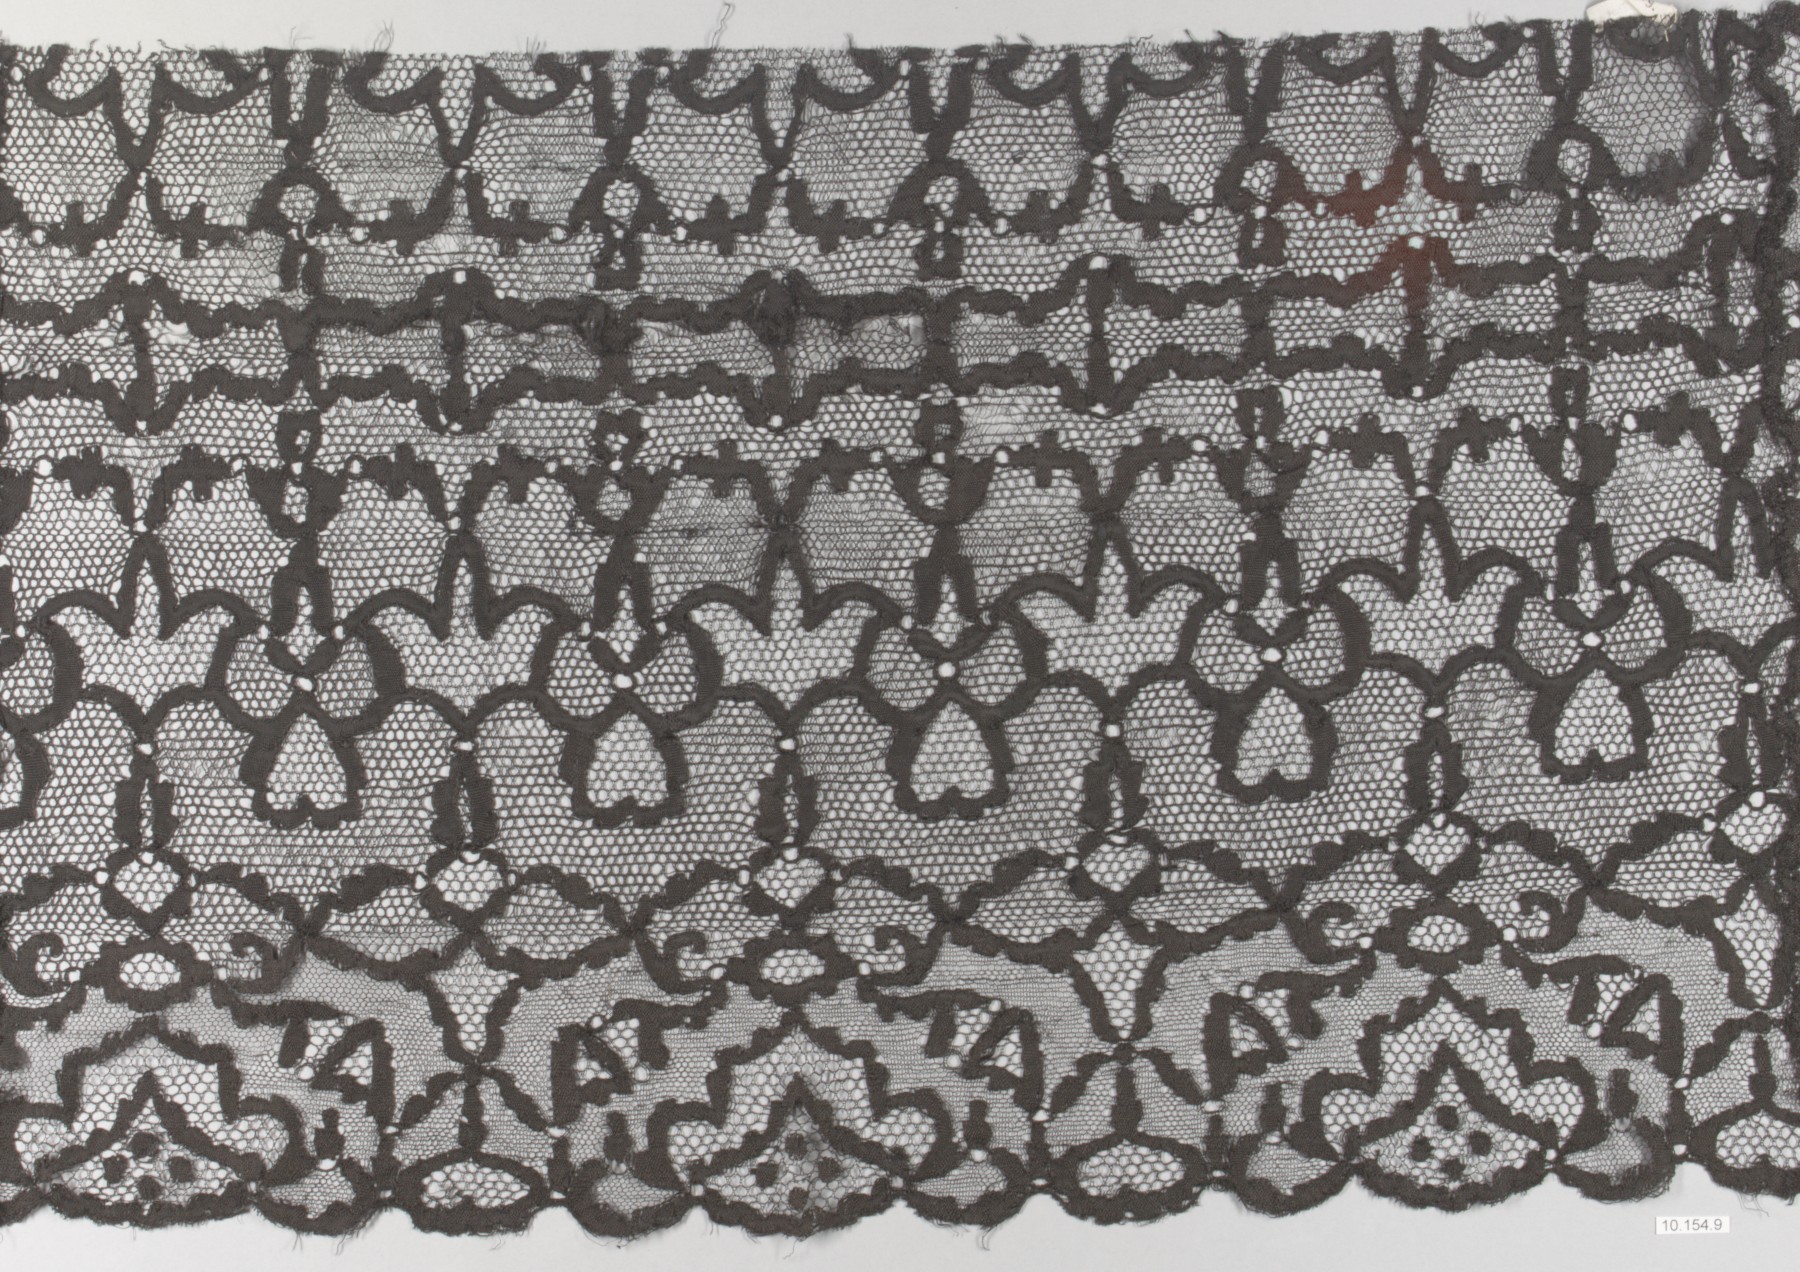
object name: flounce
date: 1801-1900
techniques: lace